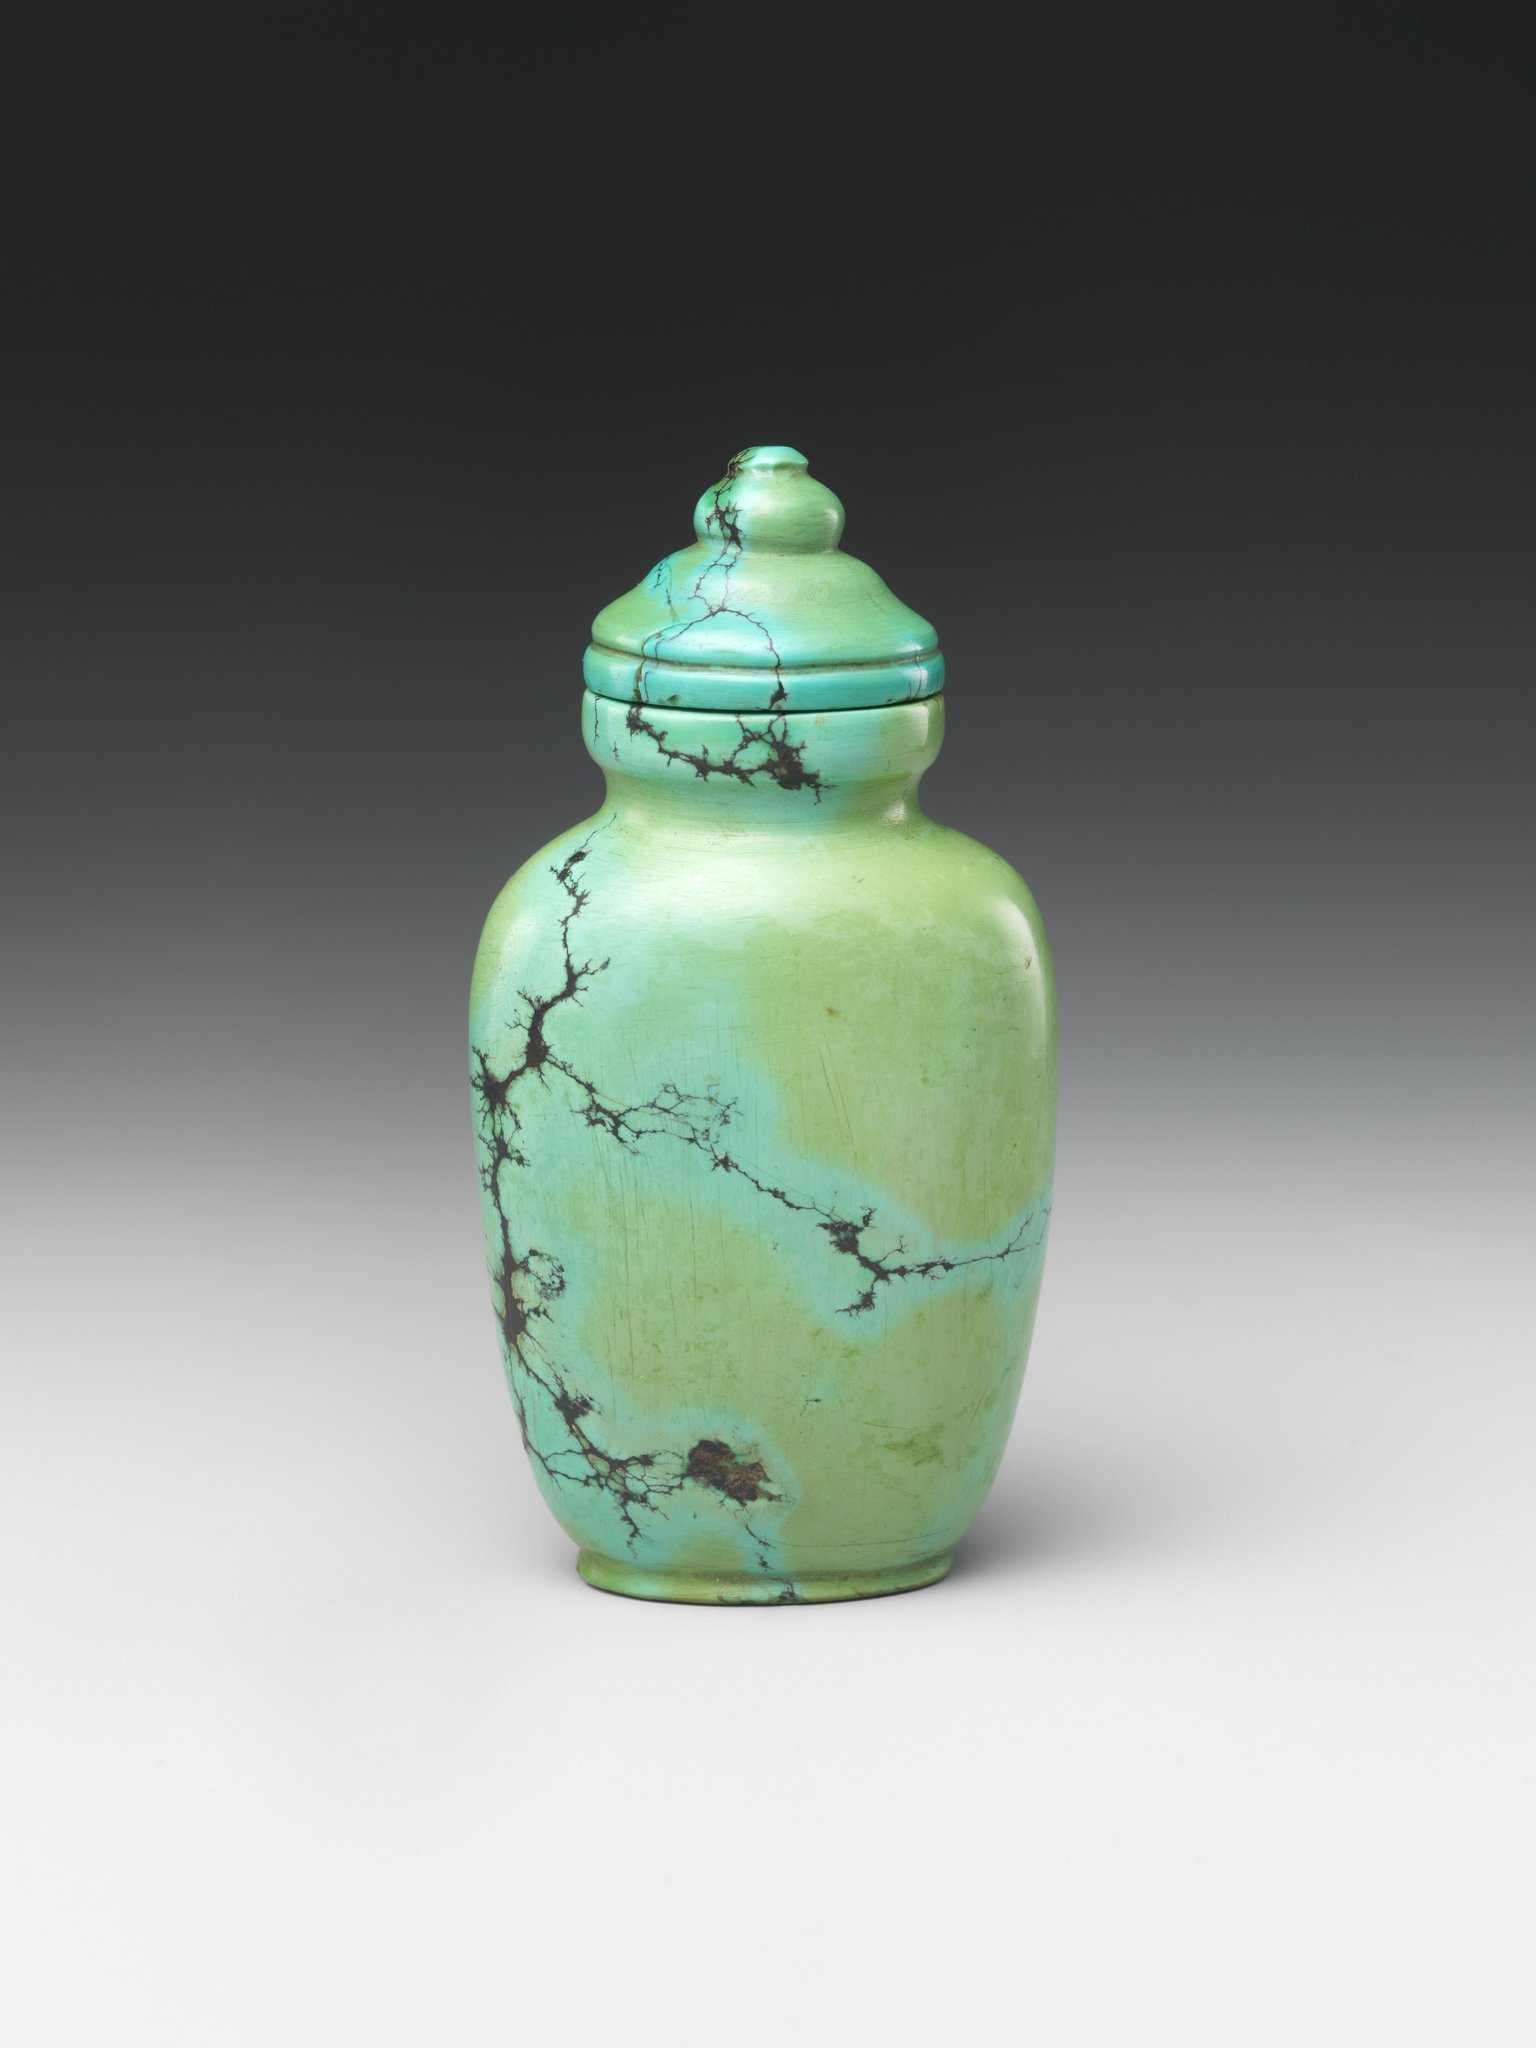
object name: snuff bottle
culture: chinese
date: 1767-1833